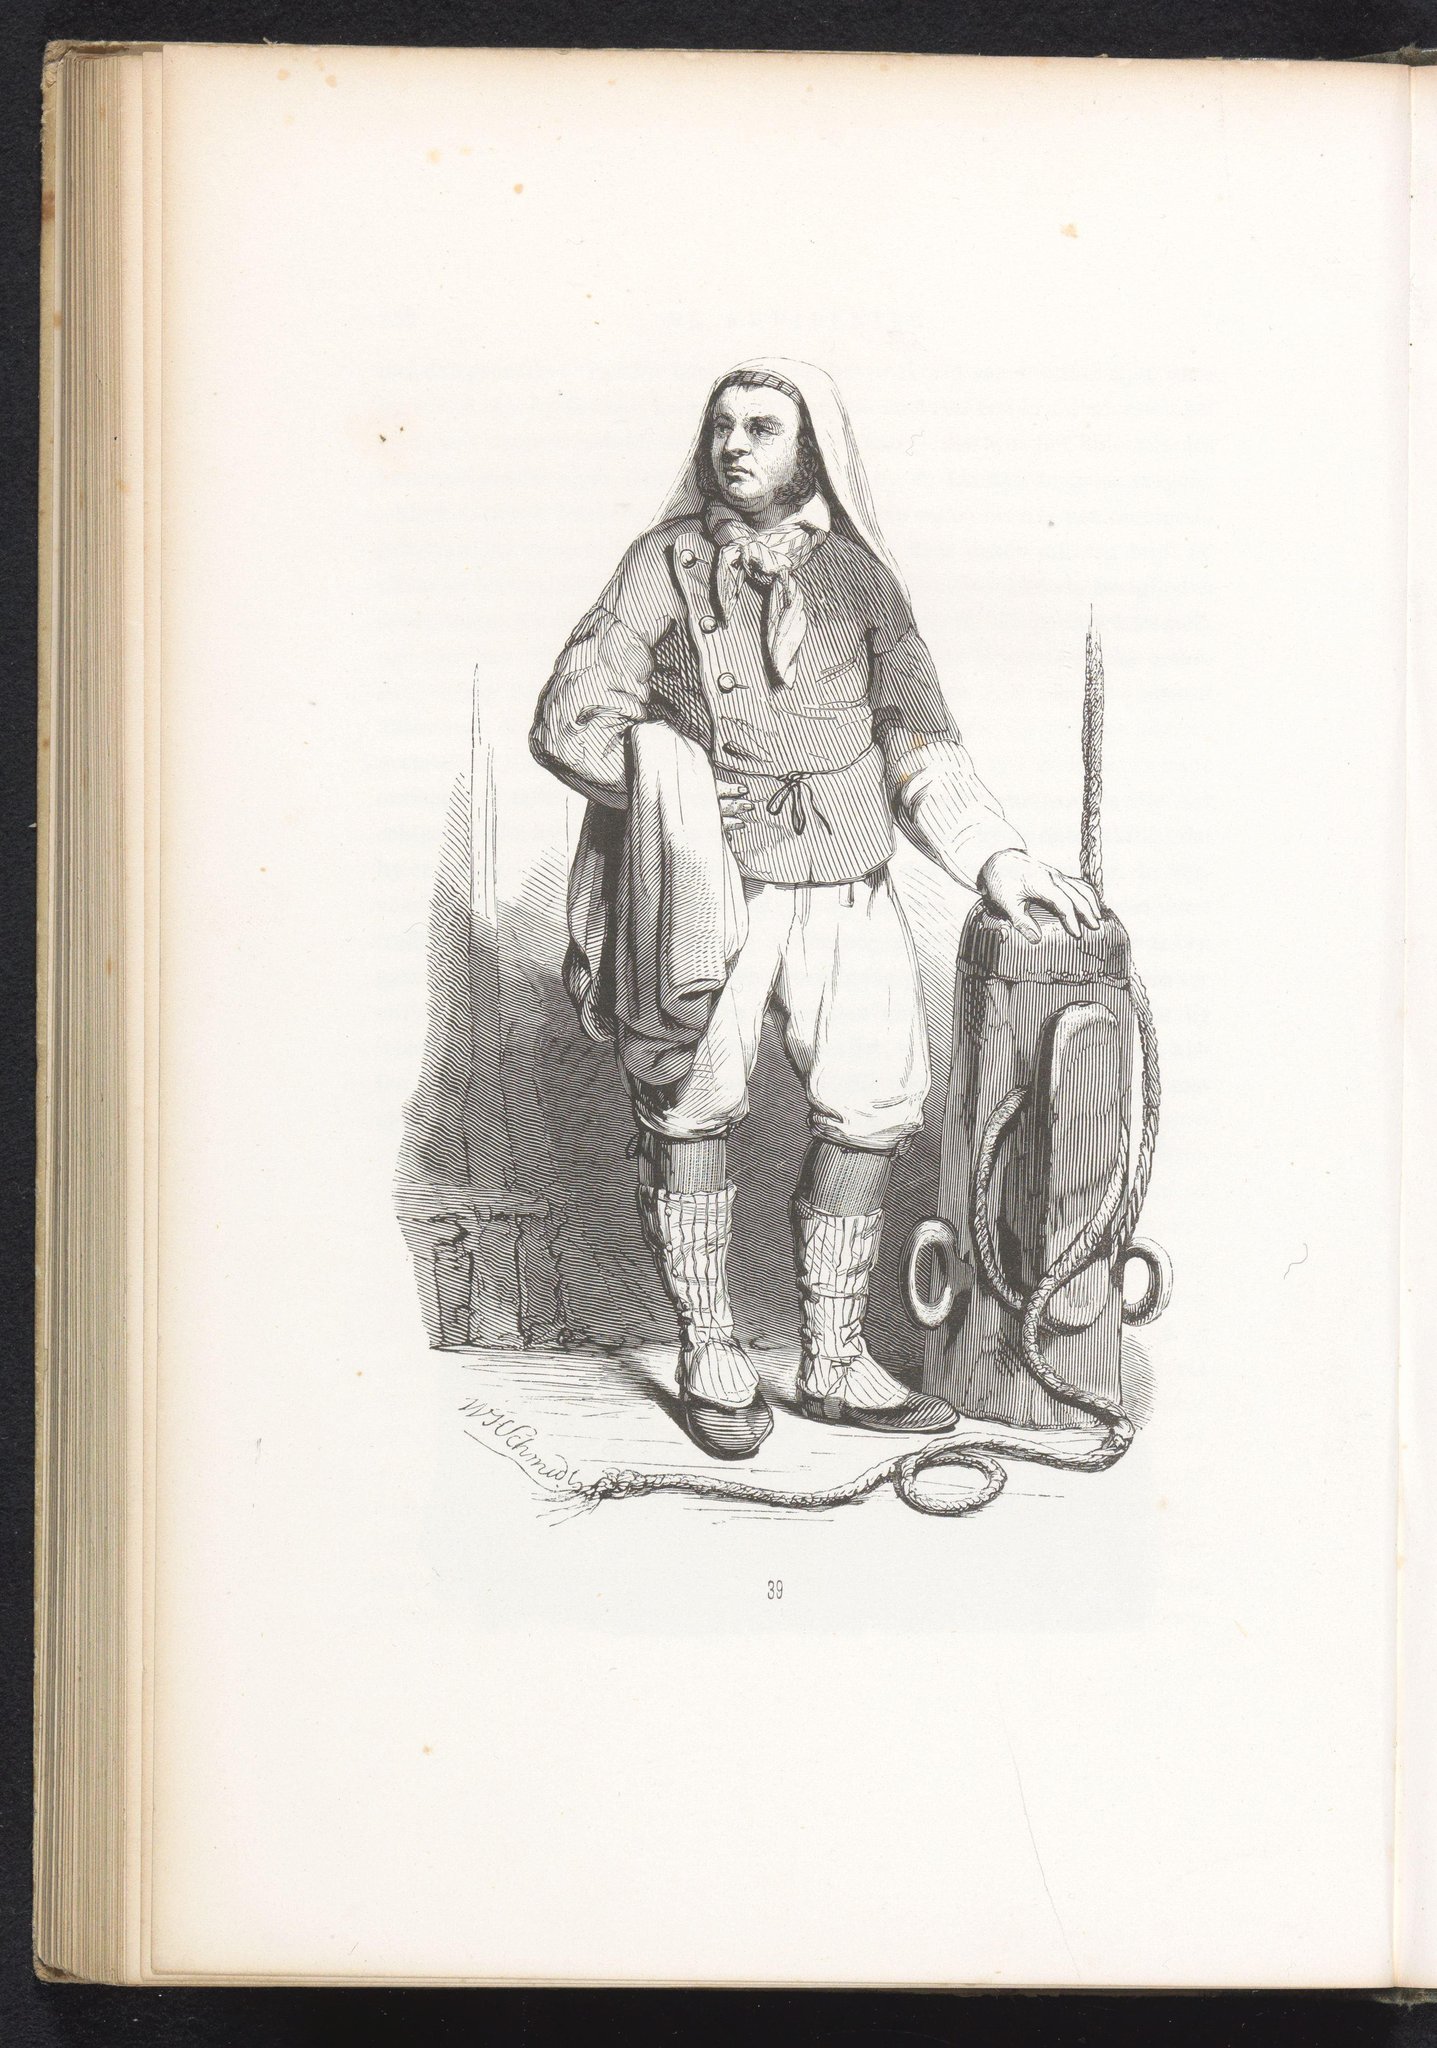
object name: print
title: De zakkendrager van Rotterdam, 1840-1841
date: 1841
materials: paper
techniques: letterpress printing, engraving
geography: the hague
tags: harbour, professional clothes, carrying something, working class, labourers, rotterdam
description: De zakkendrager van Rotterdam. Staande man bij een steigerpaal. Genummerd: 39. Illustratie in het boek 'De Nederlanden: karakterschetsen, kleederdrachten, houding en voorkomen van verschillende standen', een boek met karakterschetsen, beroepen en klederdrachten van Nederlandse volkstypen uit 1841.